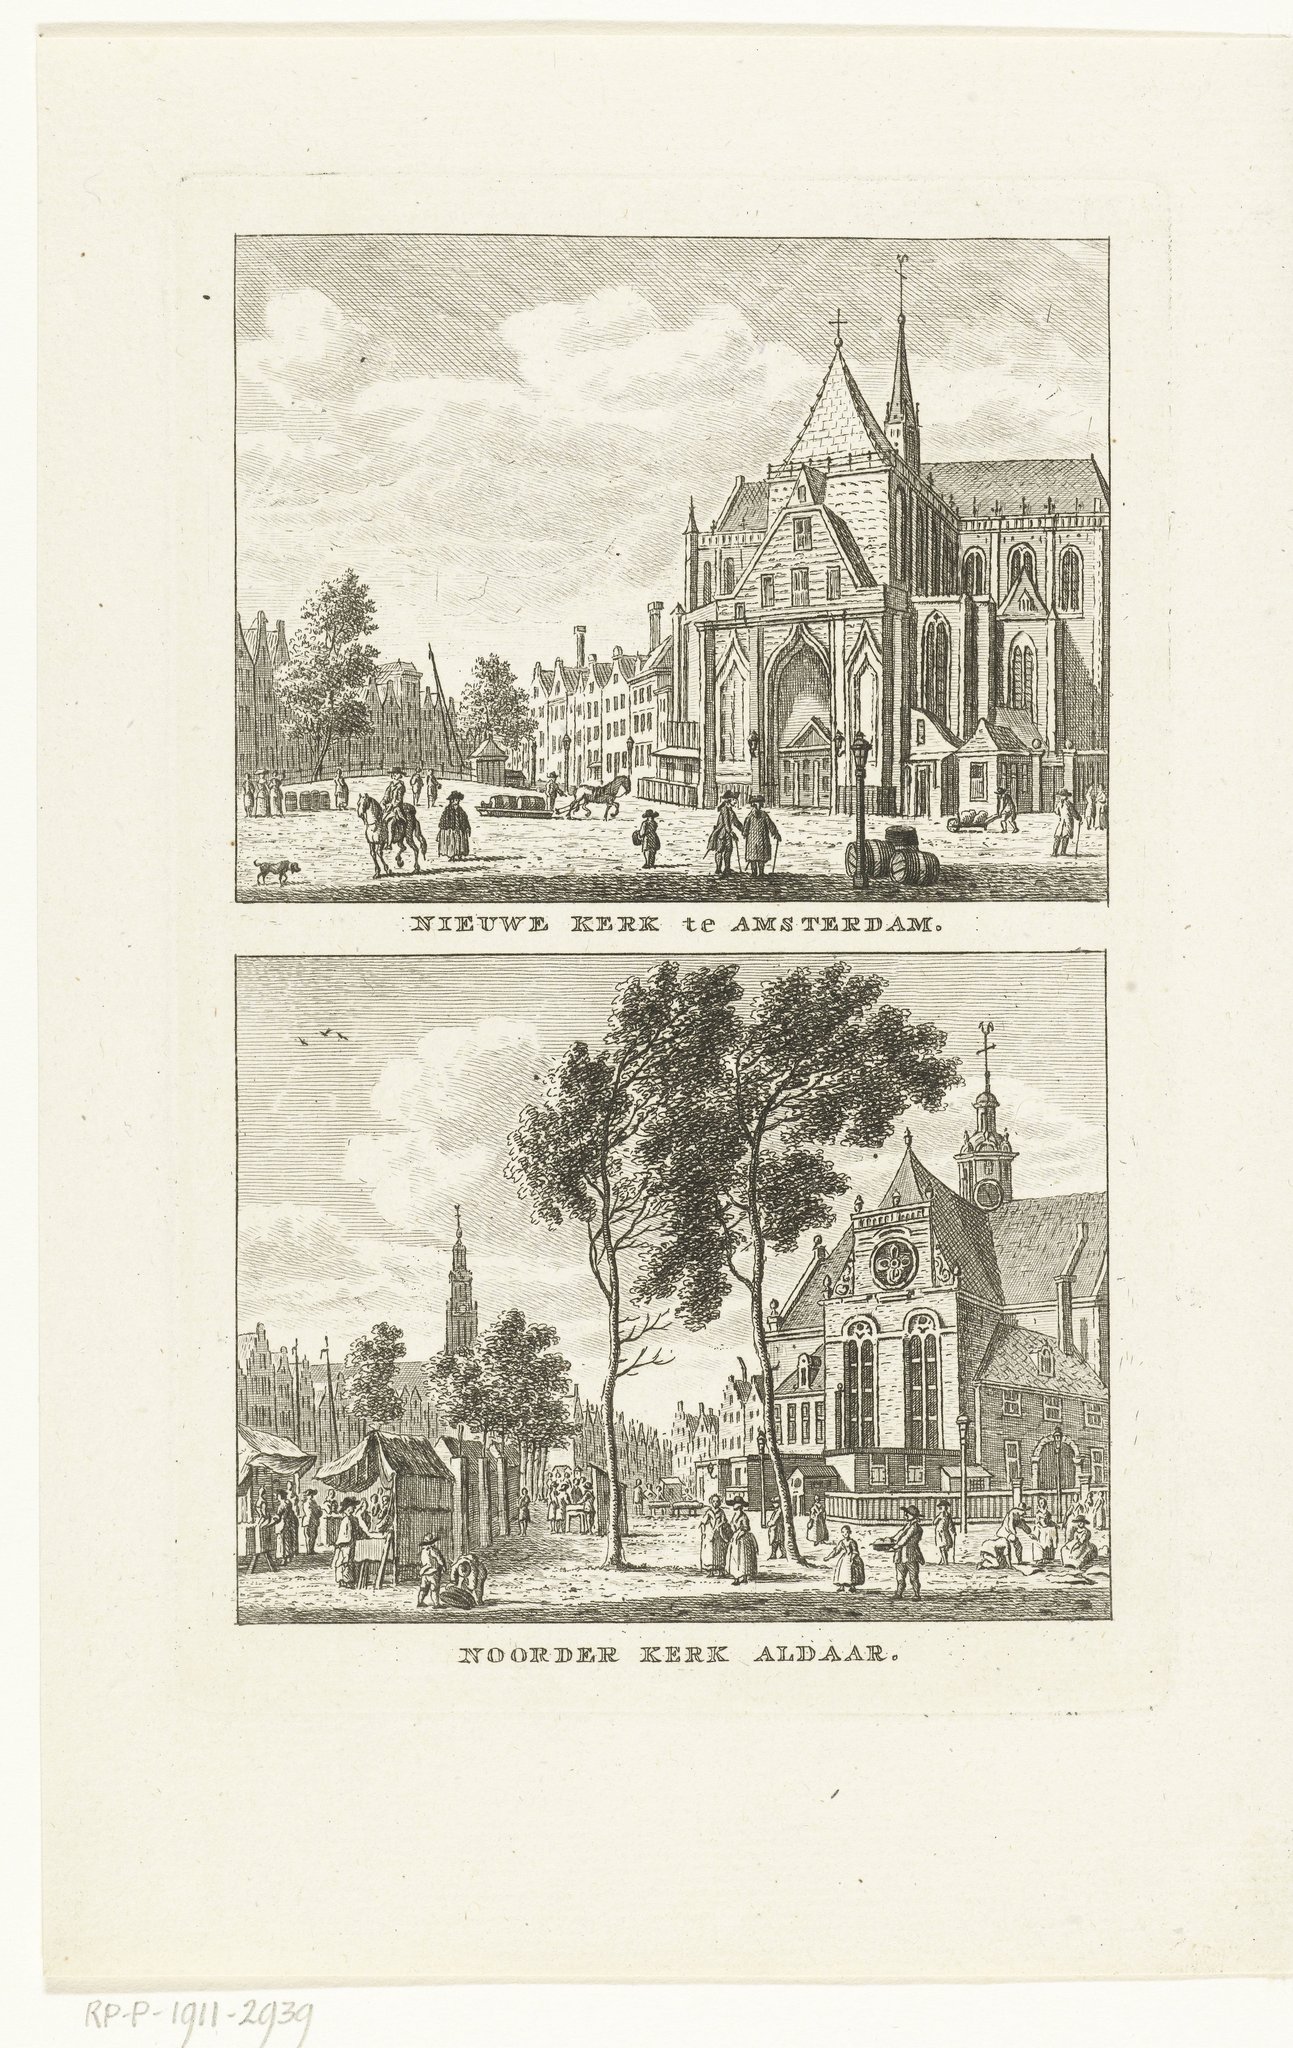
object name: print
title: Nieuwe Kerk te Amsterdam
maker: carel frederik bendorp (i)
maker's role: print maker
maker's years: 1736-1814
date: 1786-1792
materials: paper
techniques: etching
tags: city-view in general; 'veduta', church (exterior)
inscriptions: collector's mark: Lugt 2228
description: Prent uit: Vaderlandsche gezichten, of afbeeldingen van den tegenwoordigen staat der Vereenigde Nederlanden (…). Amsterdam: Hendrik Gartman, Willem Vermandel en Jan Willem Smit, 1786-1792. Uitgegeven in afleveringen met ieder een eigen bifolium en inhoudsopgave. Alle prenten in deze publicatie zijn gegraveerd door Carel Frederik Bendorp (I) en, in de meeste gevallen, gebaseerd op tekeningen van Jan Bulthuis.